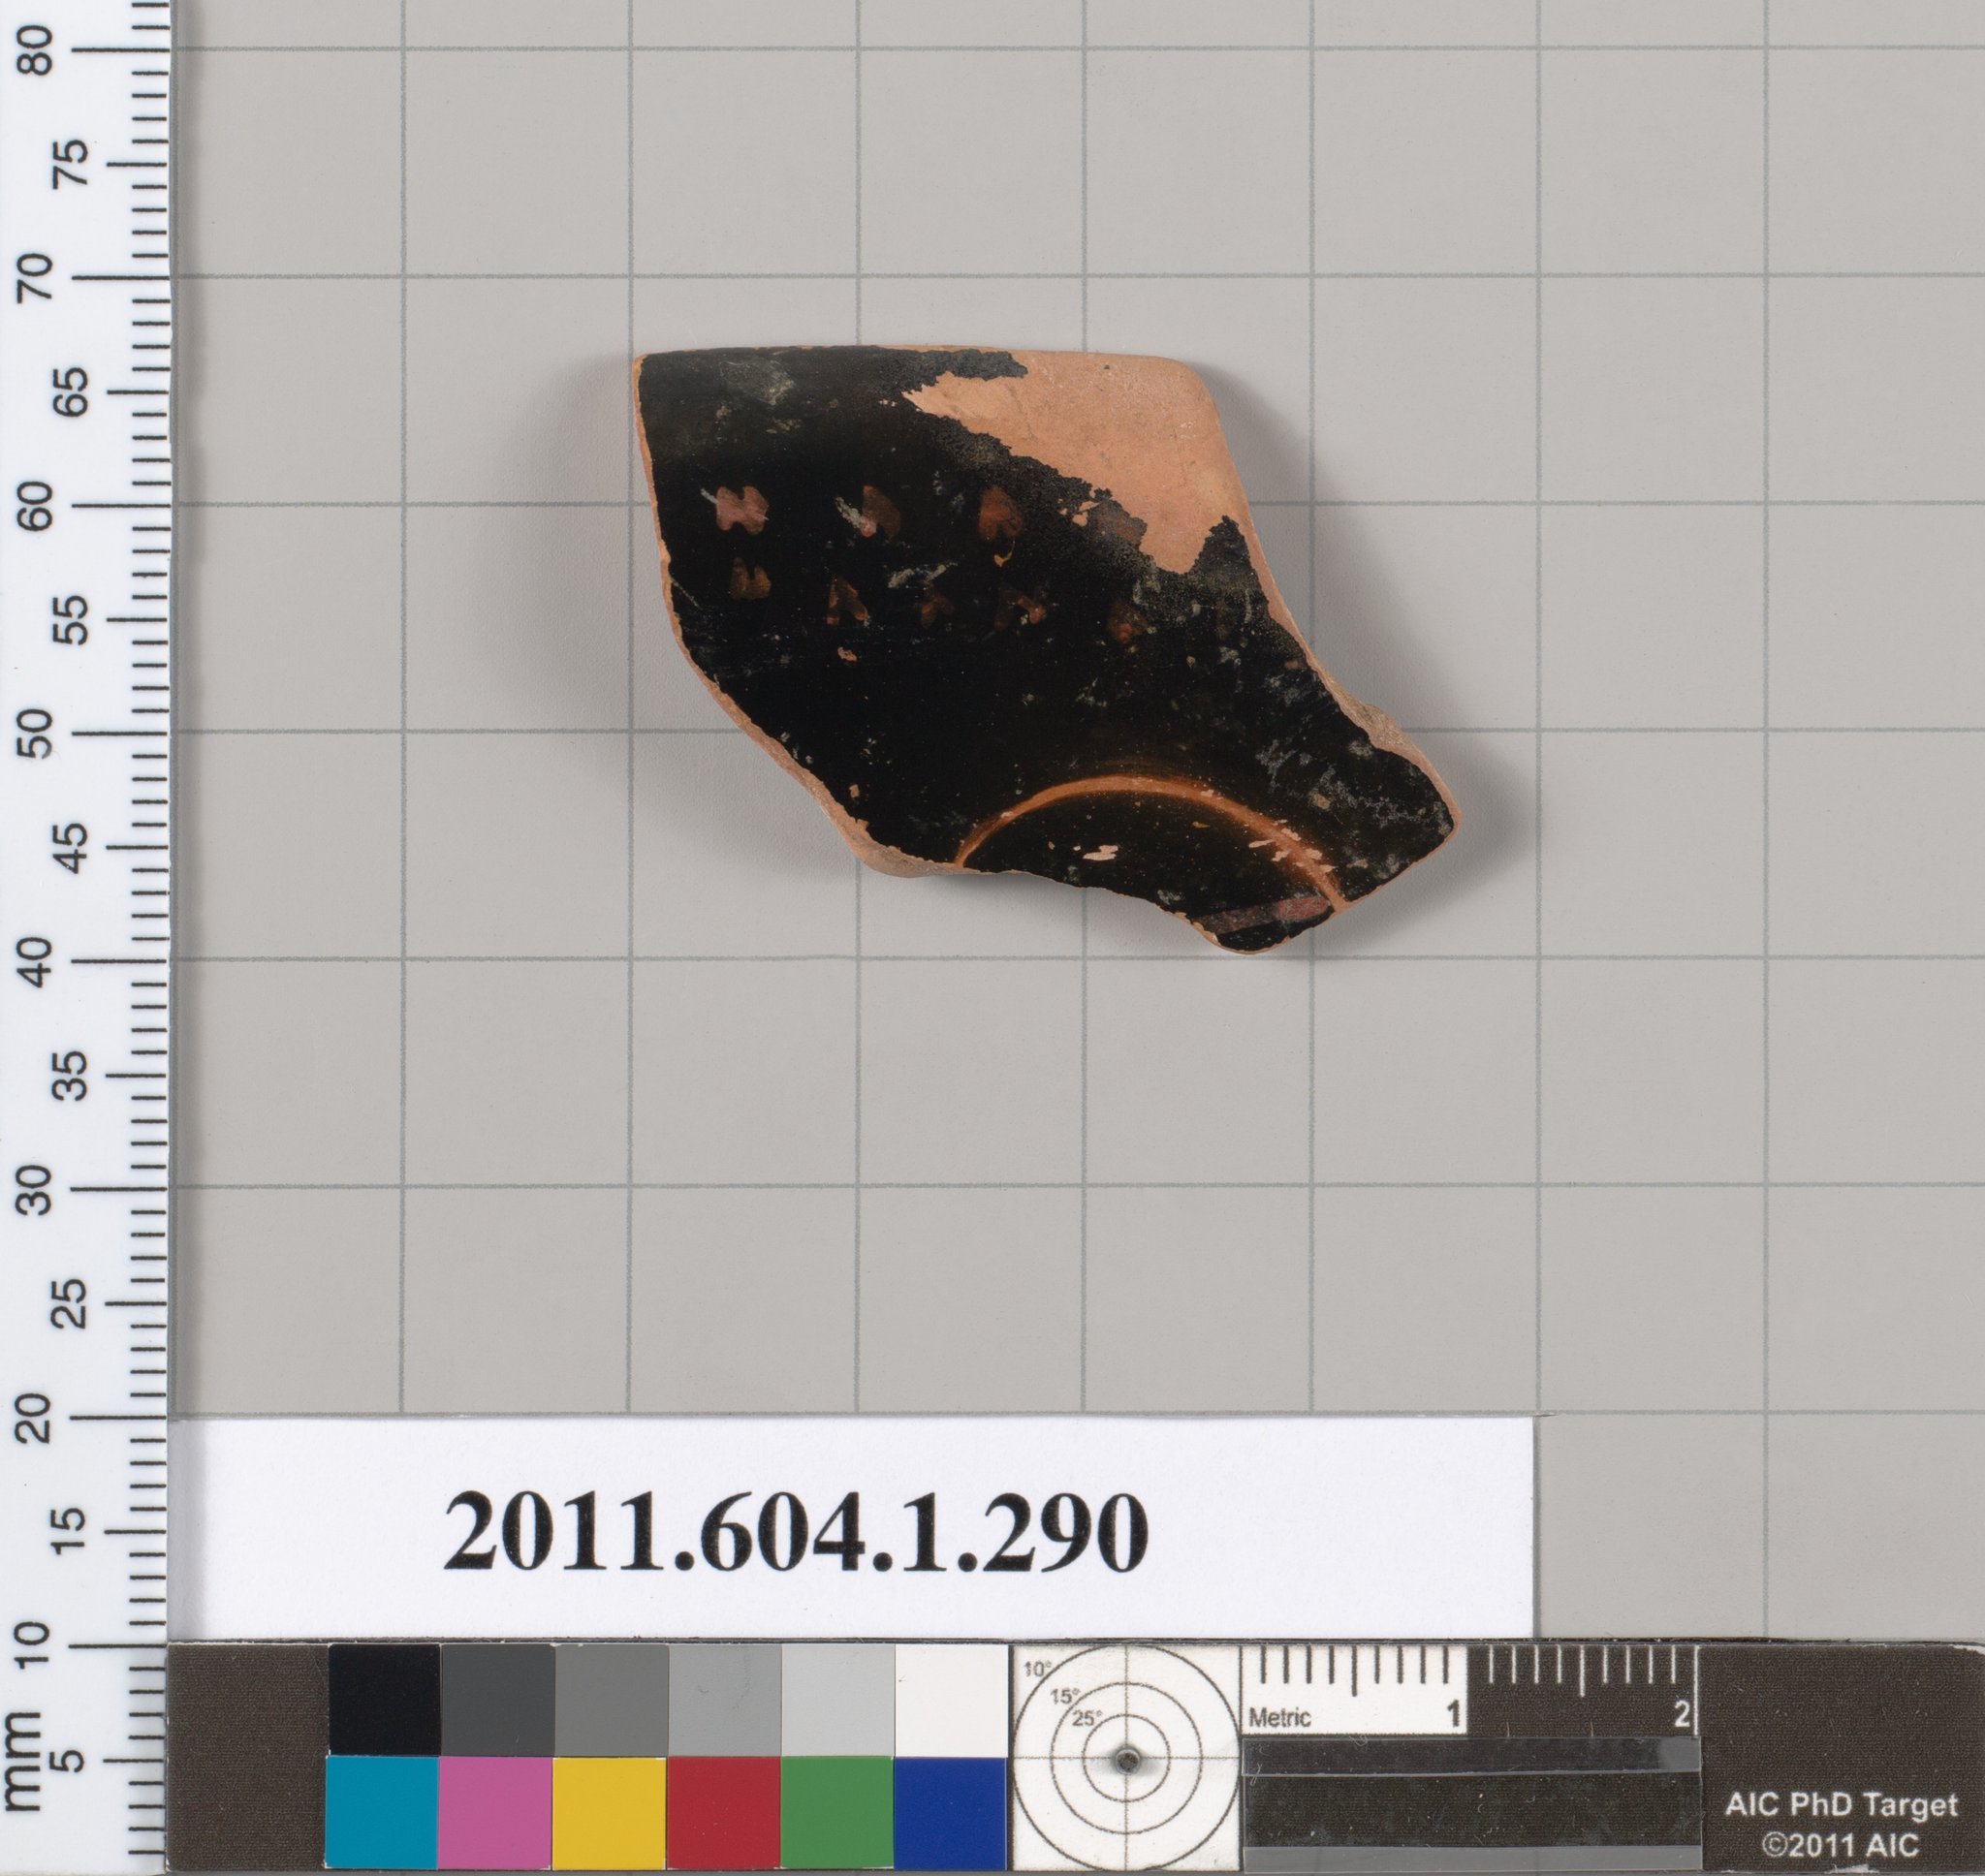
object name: kylix fragment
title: Terracotta rim fragment of a kylix (drinking cup)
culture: greek, attic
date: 475-451 BCE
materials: terracotta